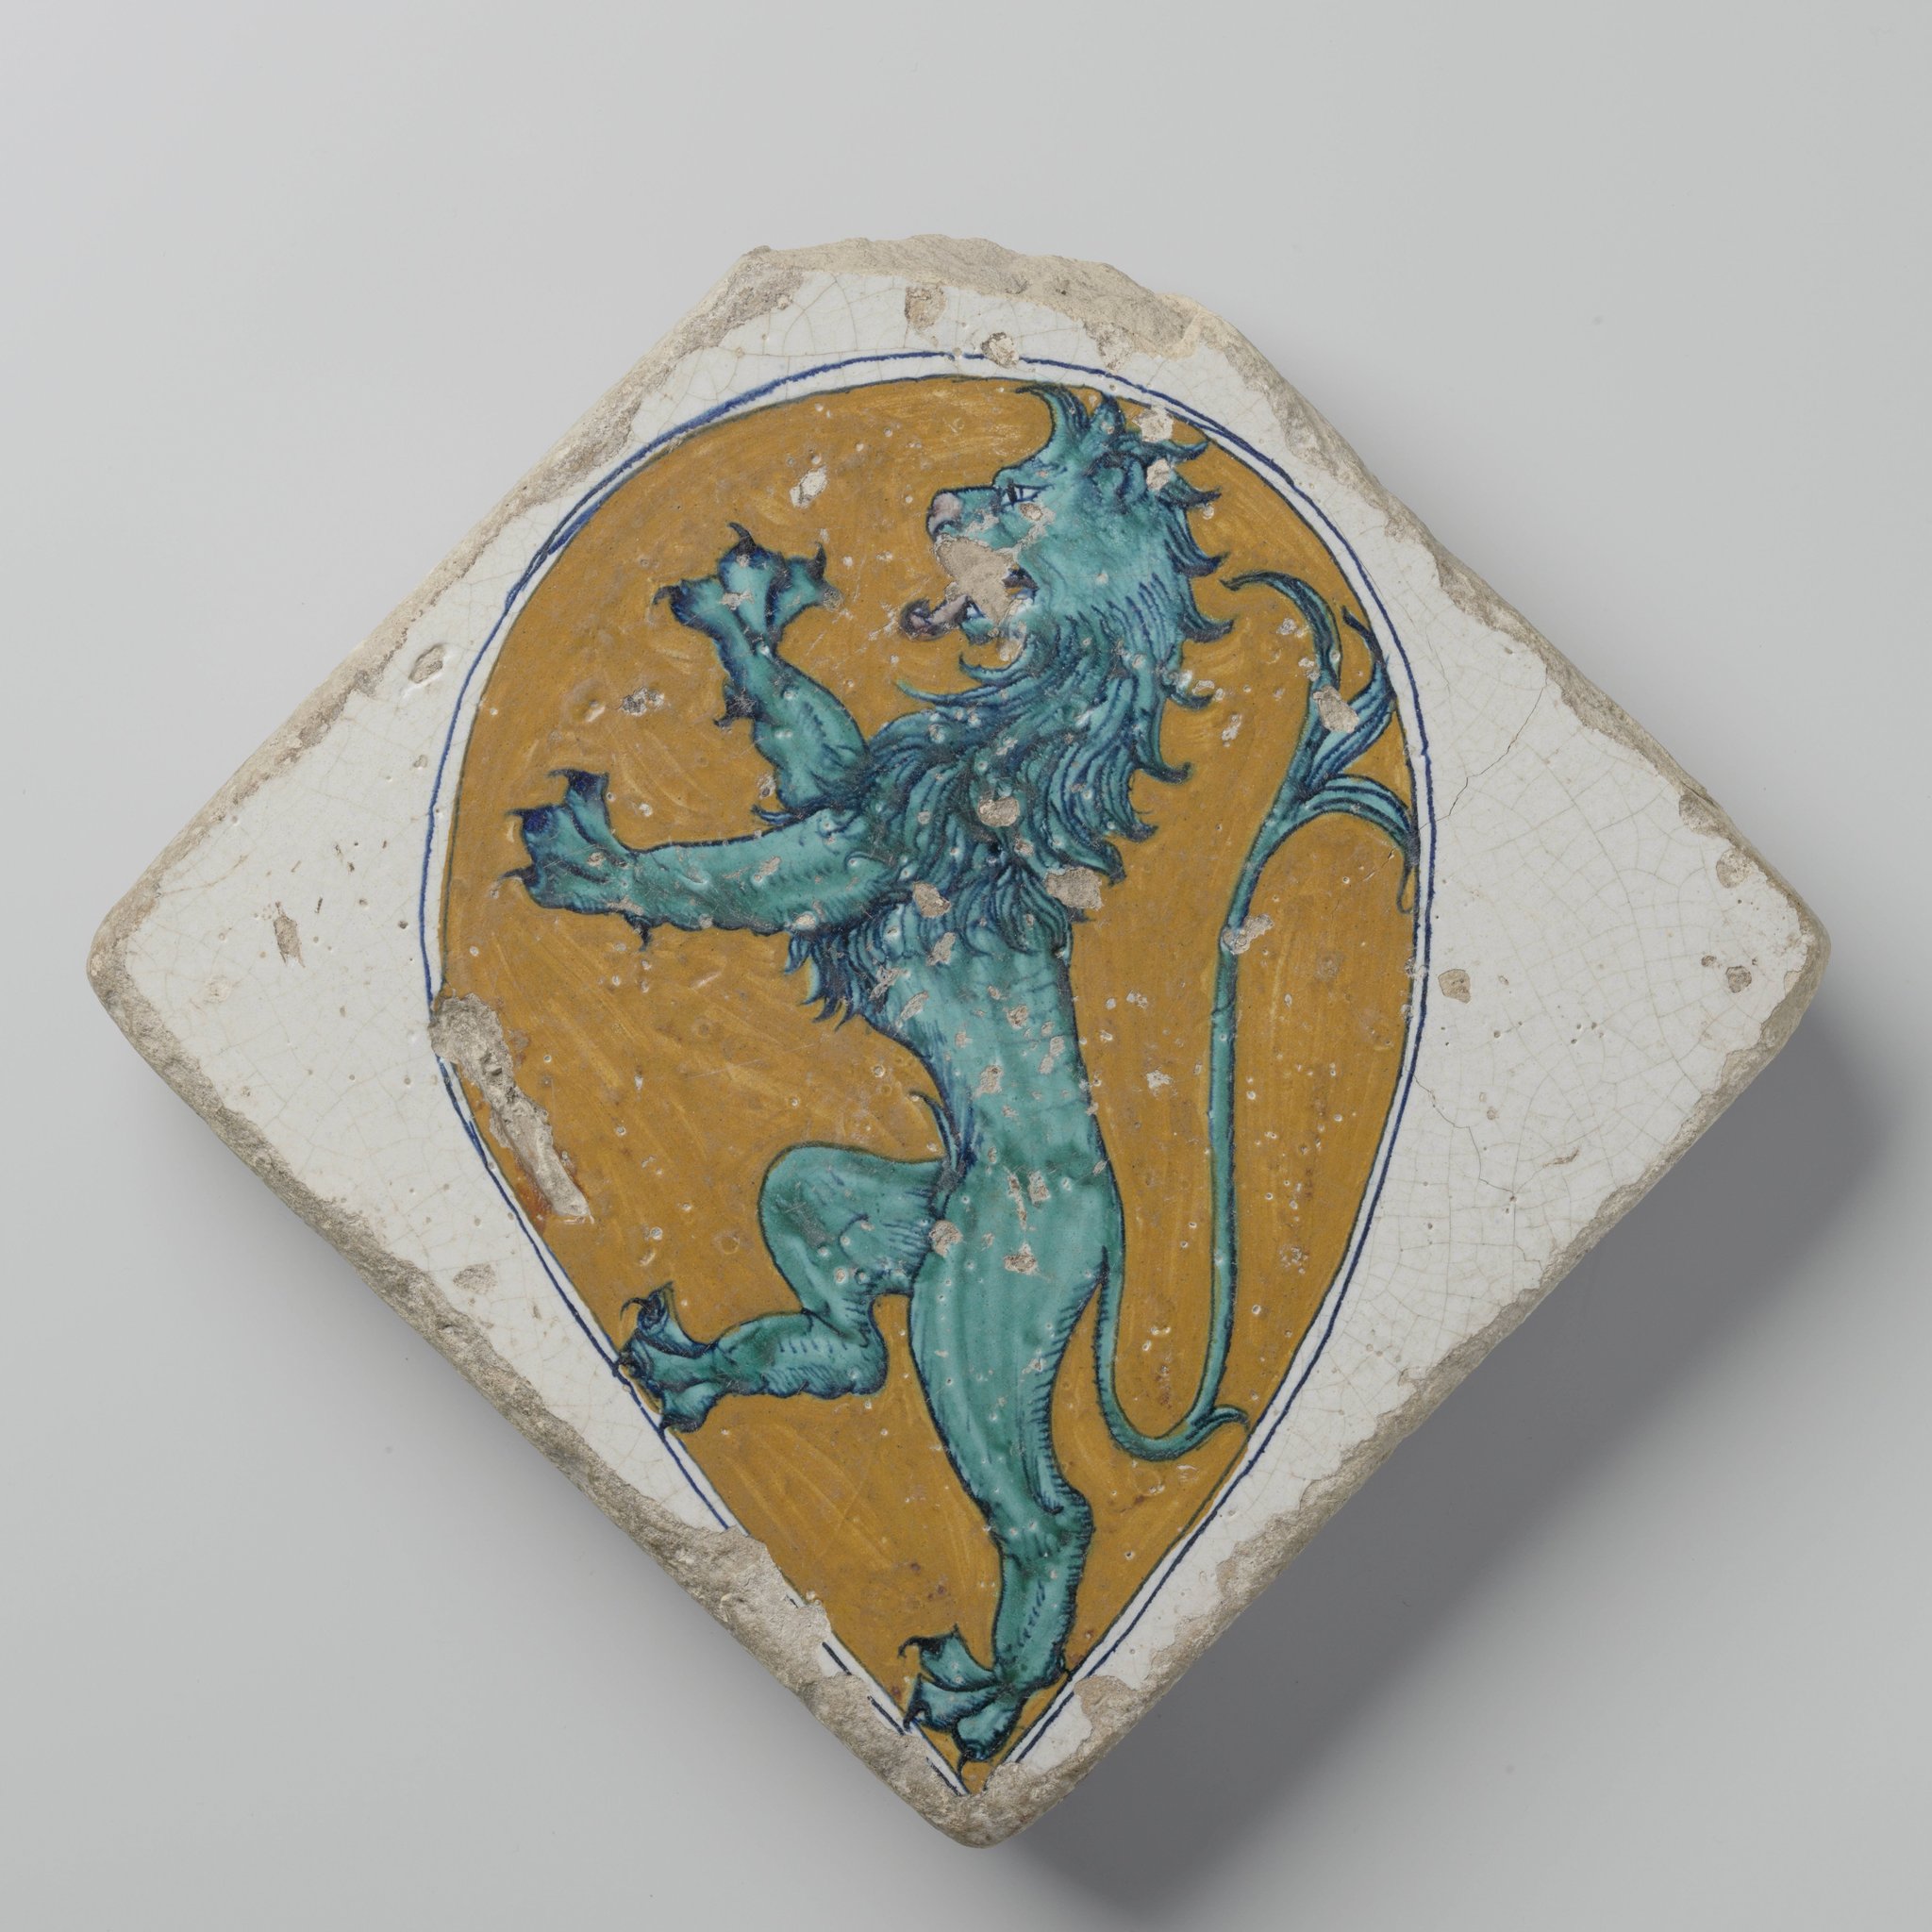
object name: tile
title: Tegel met wapen familie Ordelaffi met klimmende leeuw in een ovaal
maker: Anonymous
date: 1480-1490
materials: earthenware, glaze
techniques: maiolica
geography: faenza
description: Tile with the arms of the Ordelaffi family, rulers of Forli. Faenza, c. 1480 - 1490.